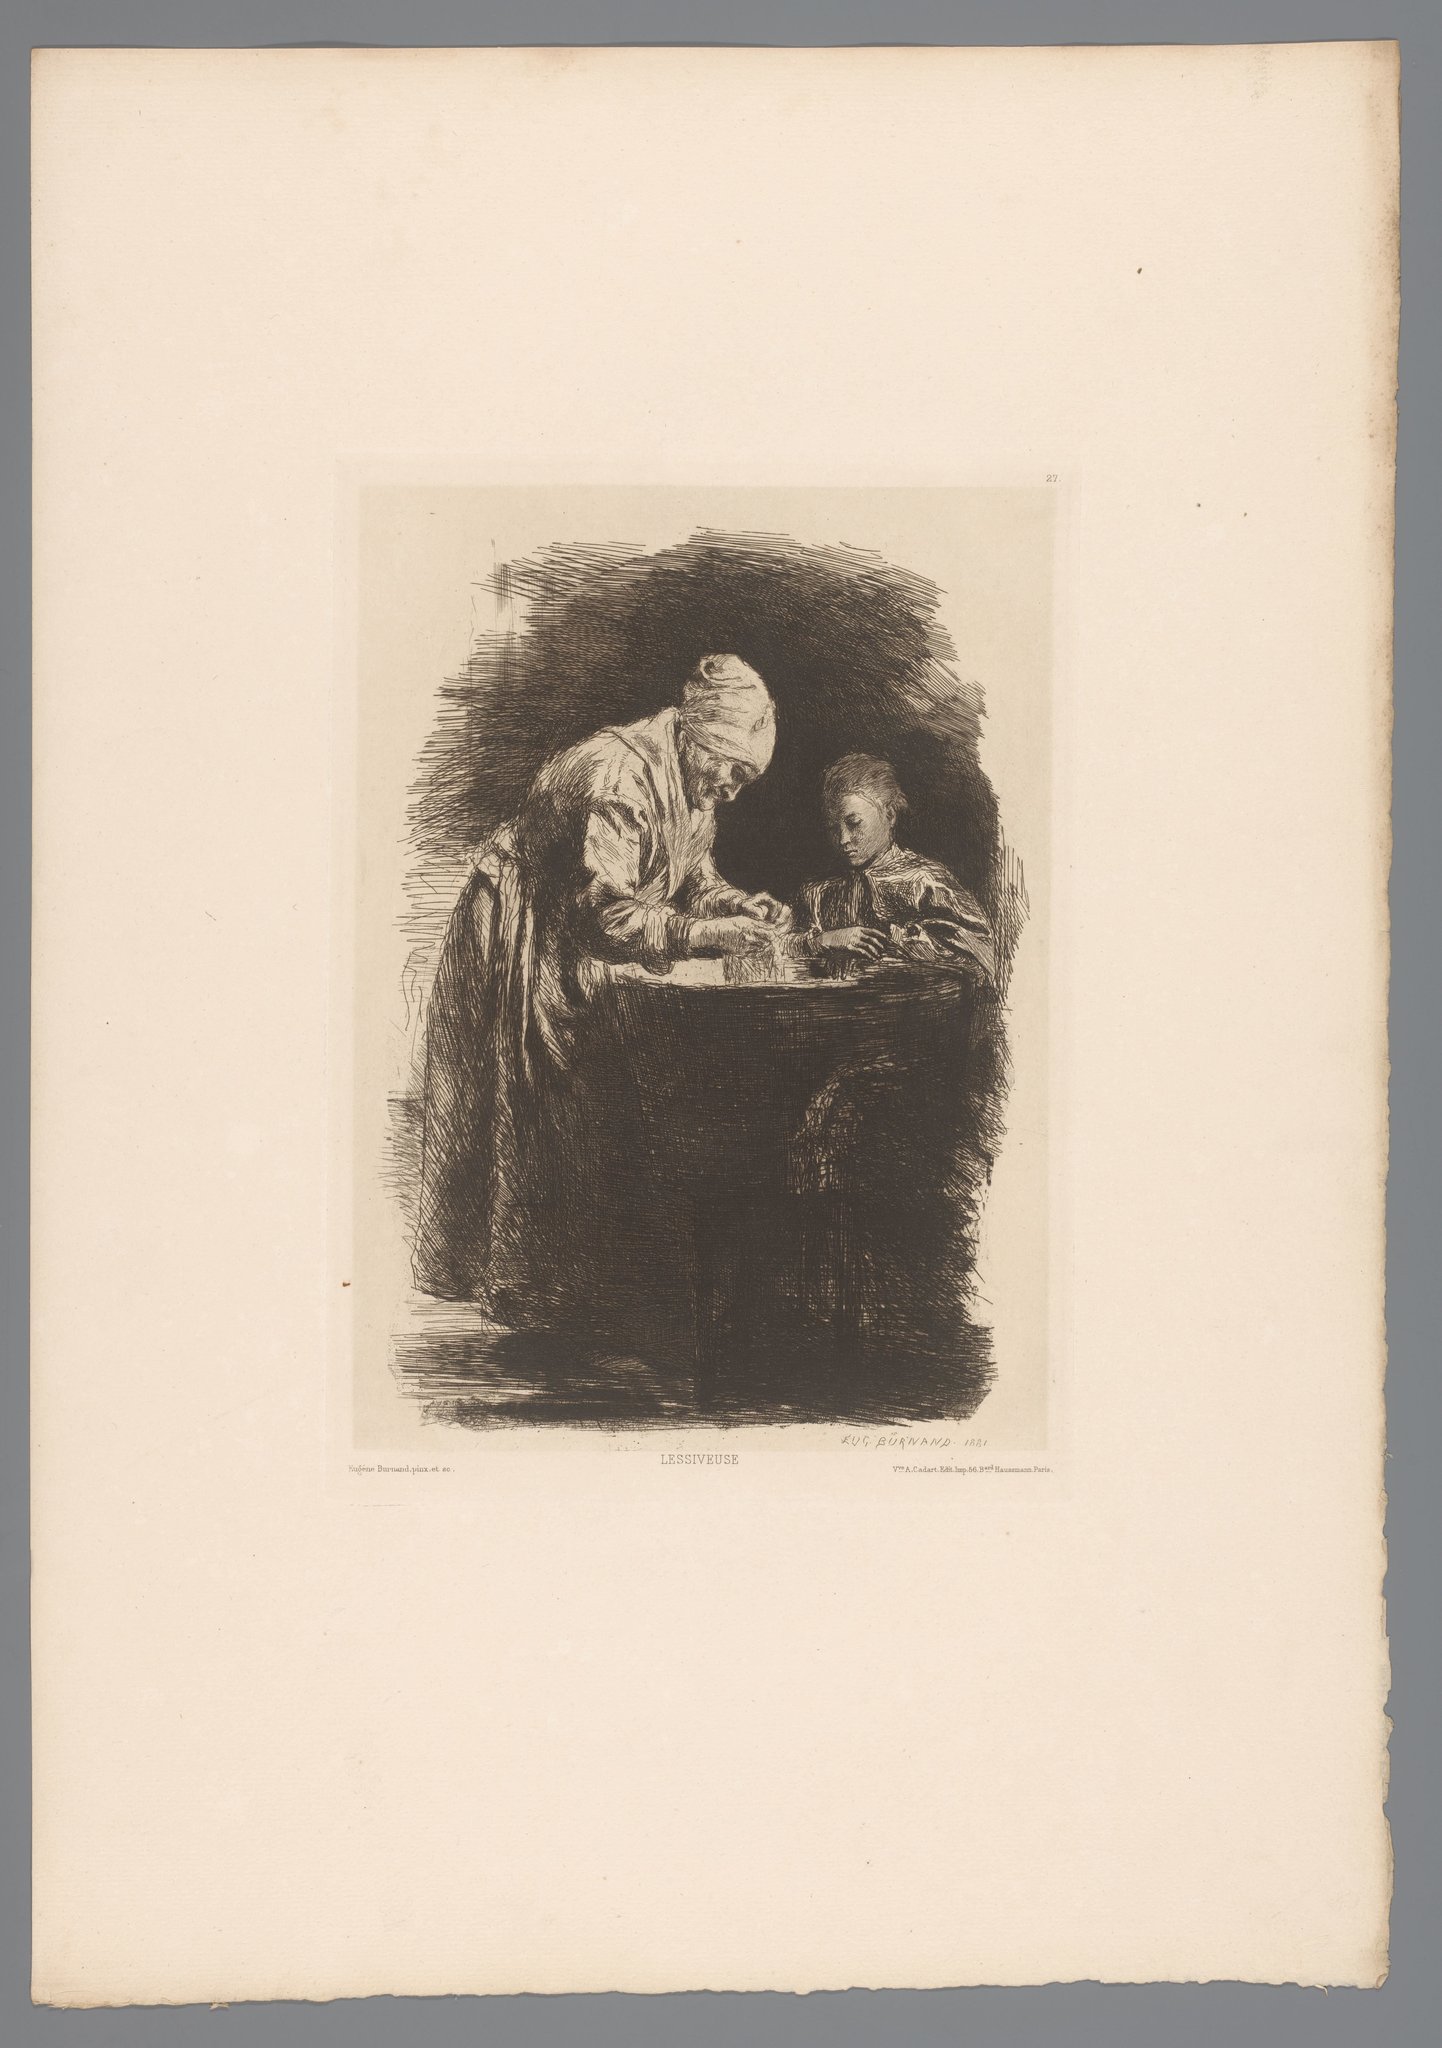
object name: print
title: Lessiveuse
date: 1881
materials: paper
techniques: drypoint, etching, intaglio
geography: paris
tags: laundering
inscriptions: collector's mark: Lugt 2228, collector's mark: Lugt 2760, collector's mark: ‘AFE v S’